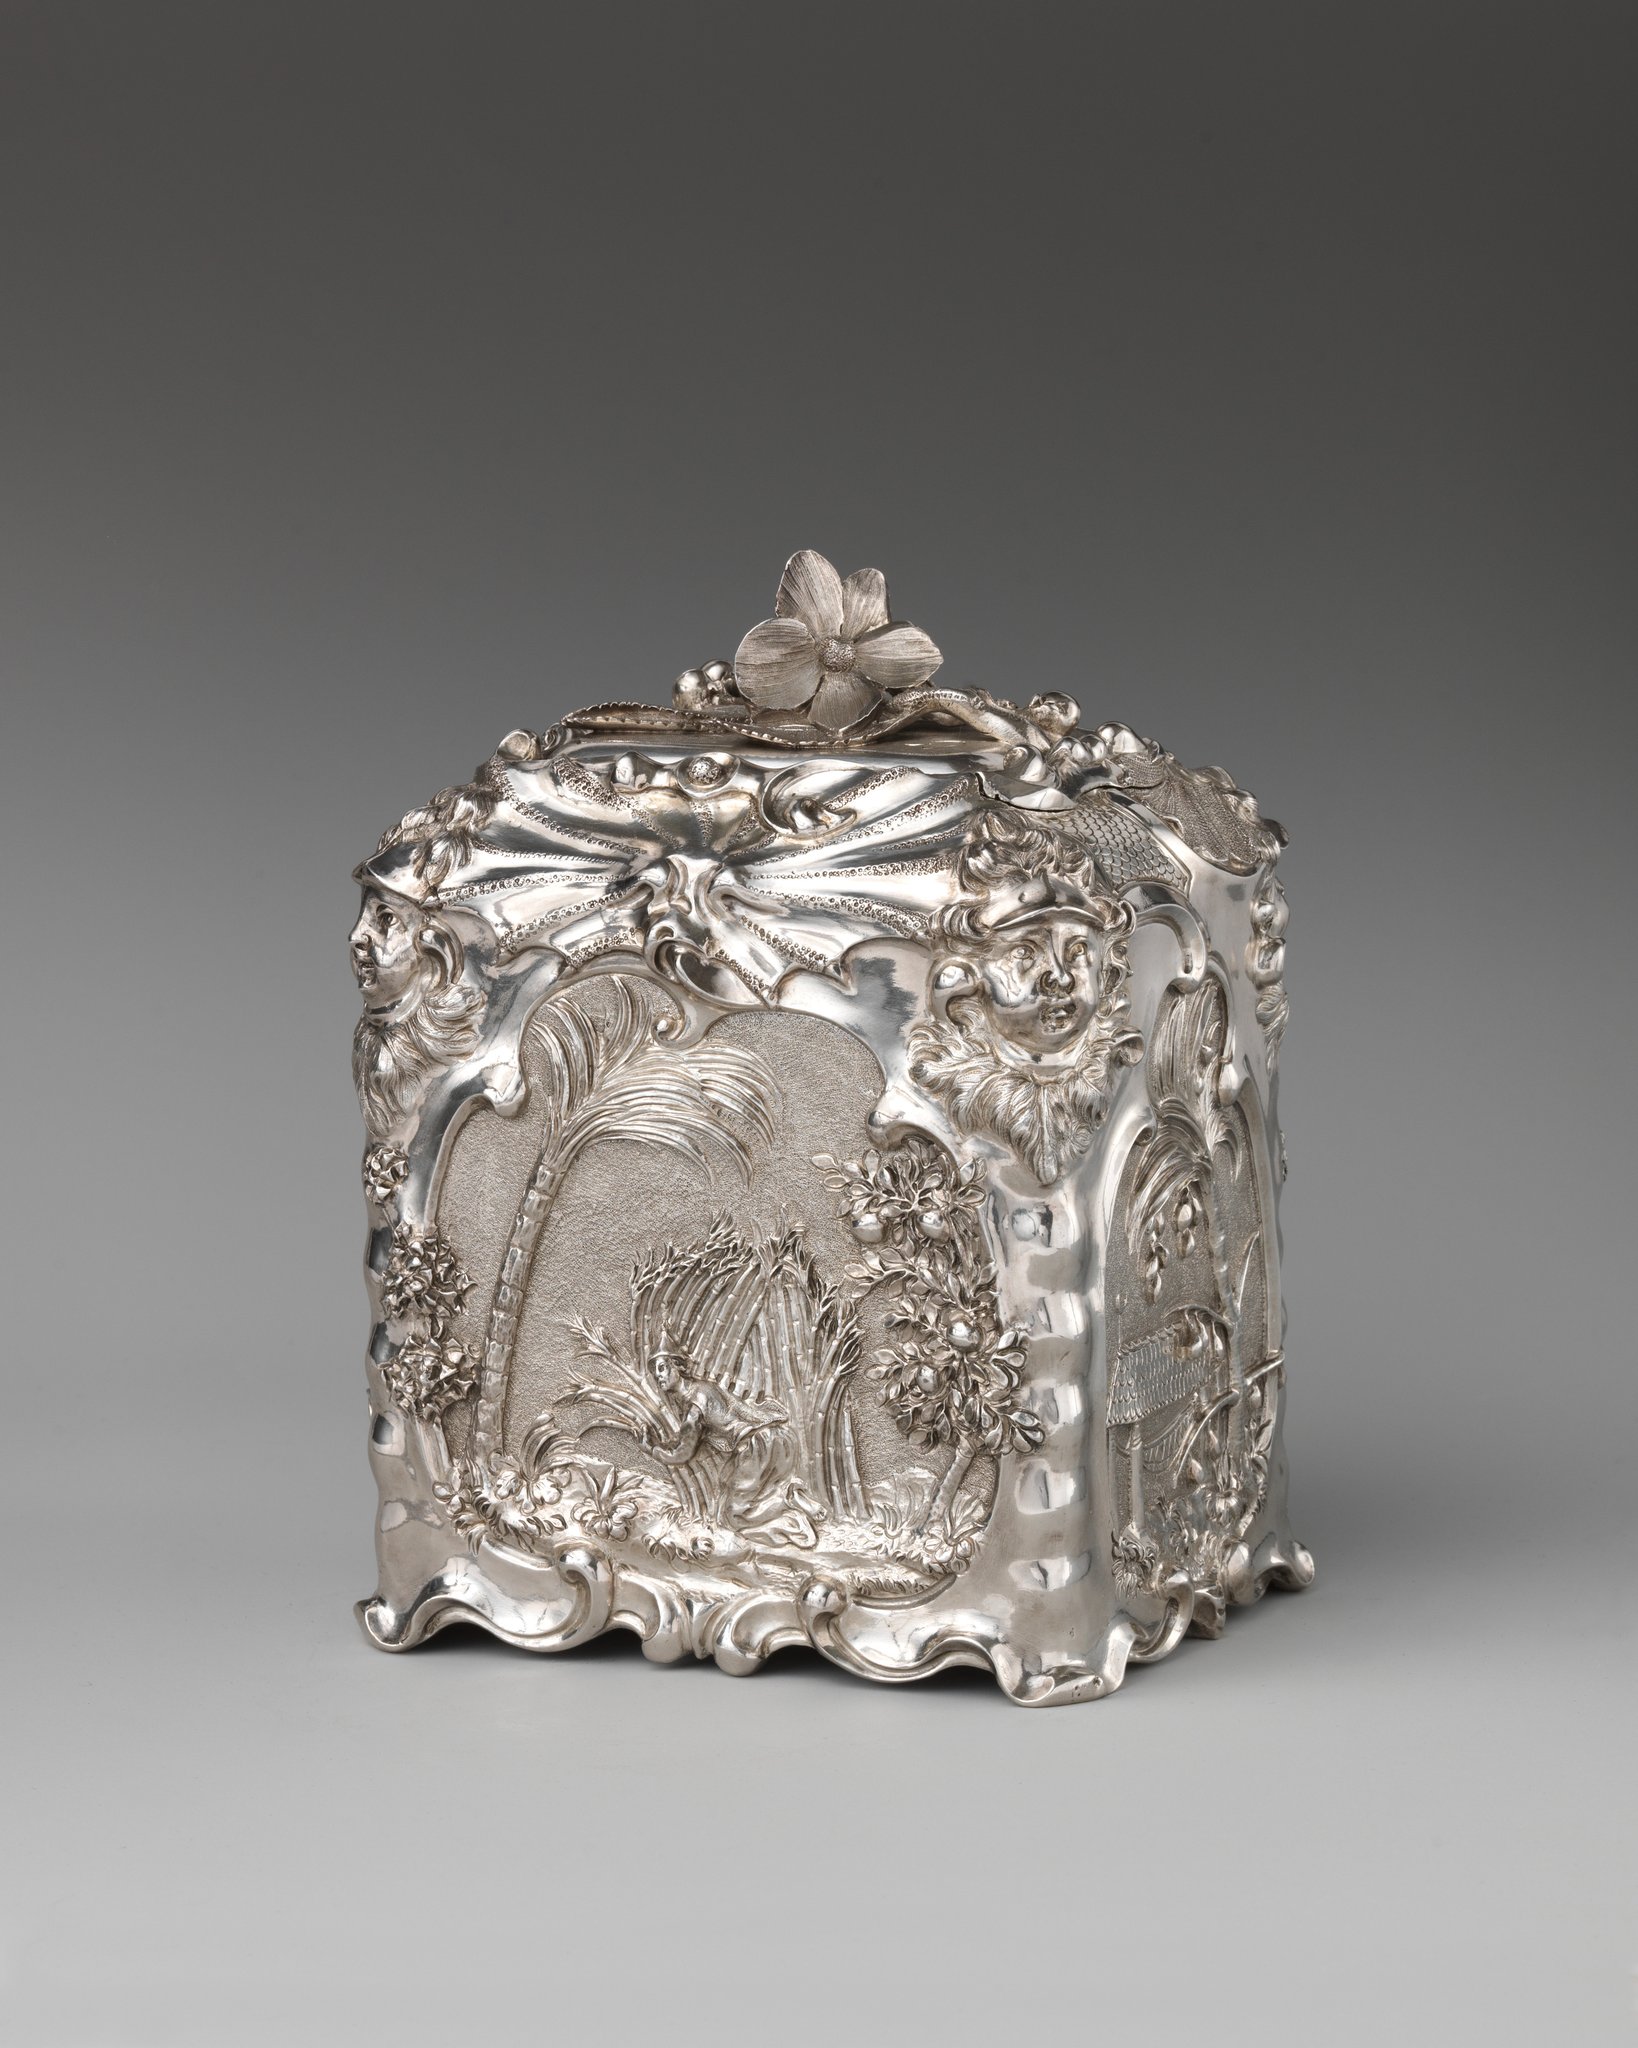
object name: sugar box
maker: paul de lamerie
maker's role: maker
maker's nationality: british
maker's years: 1688-1751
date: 1744-1745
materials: silver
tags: human figures,faces,flowers